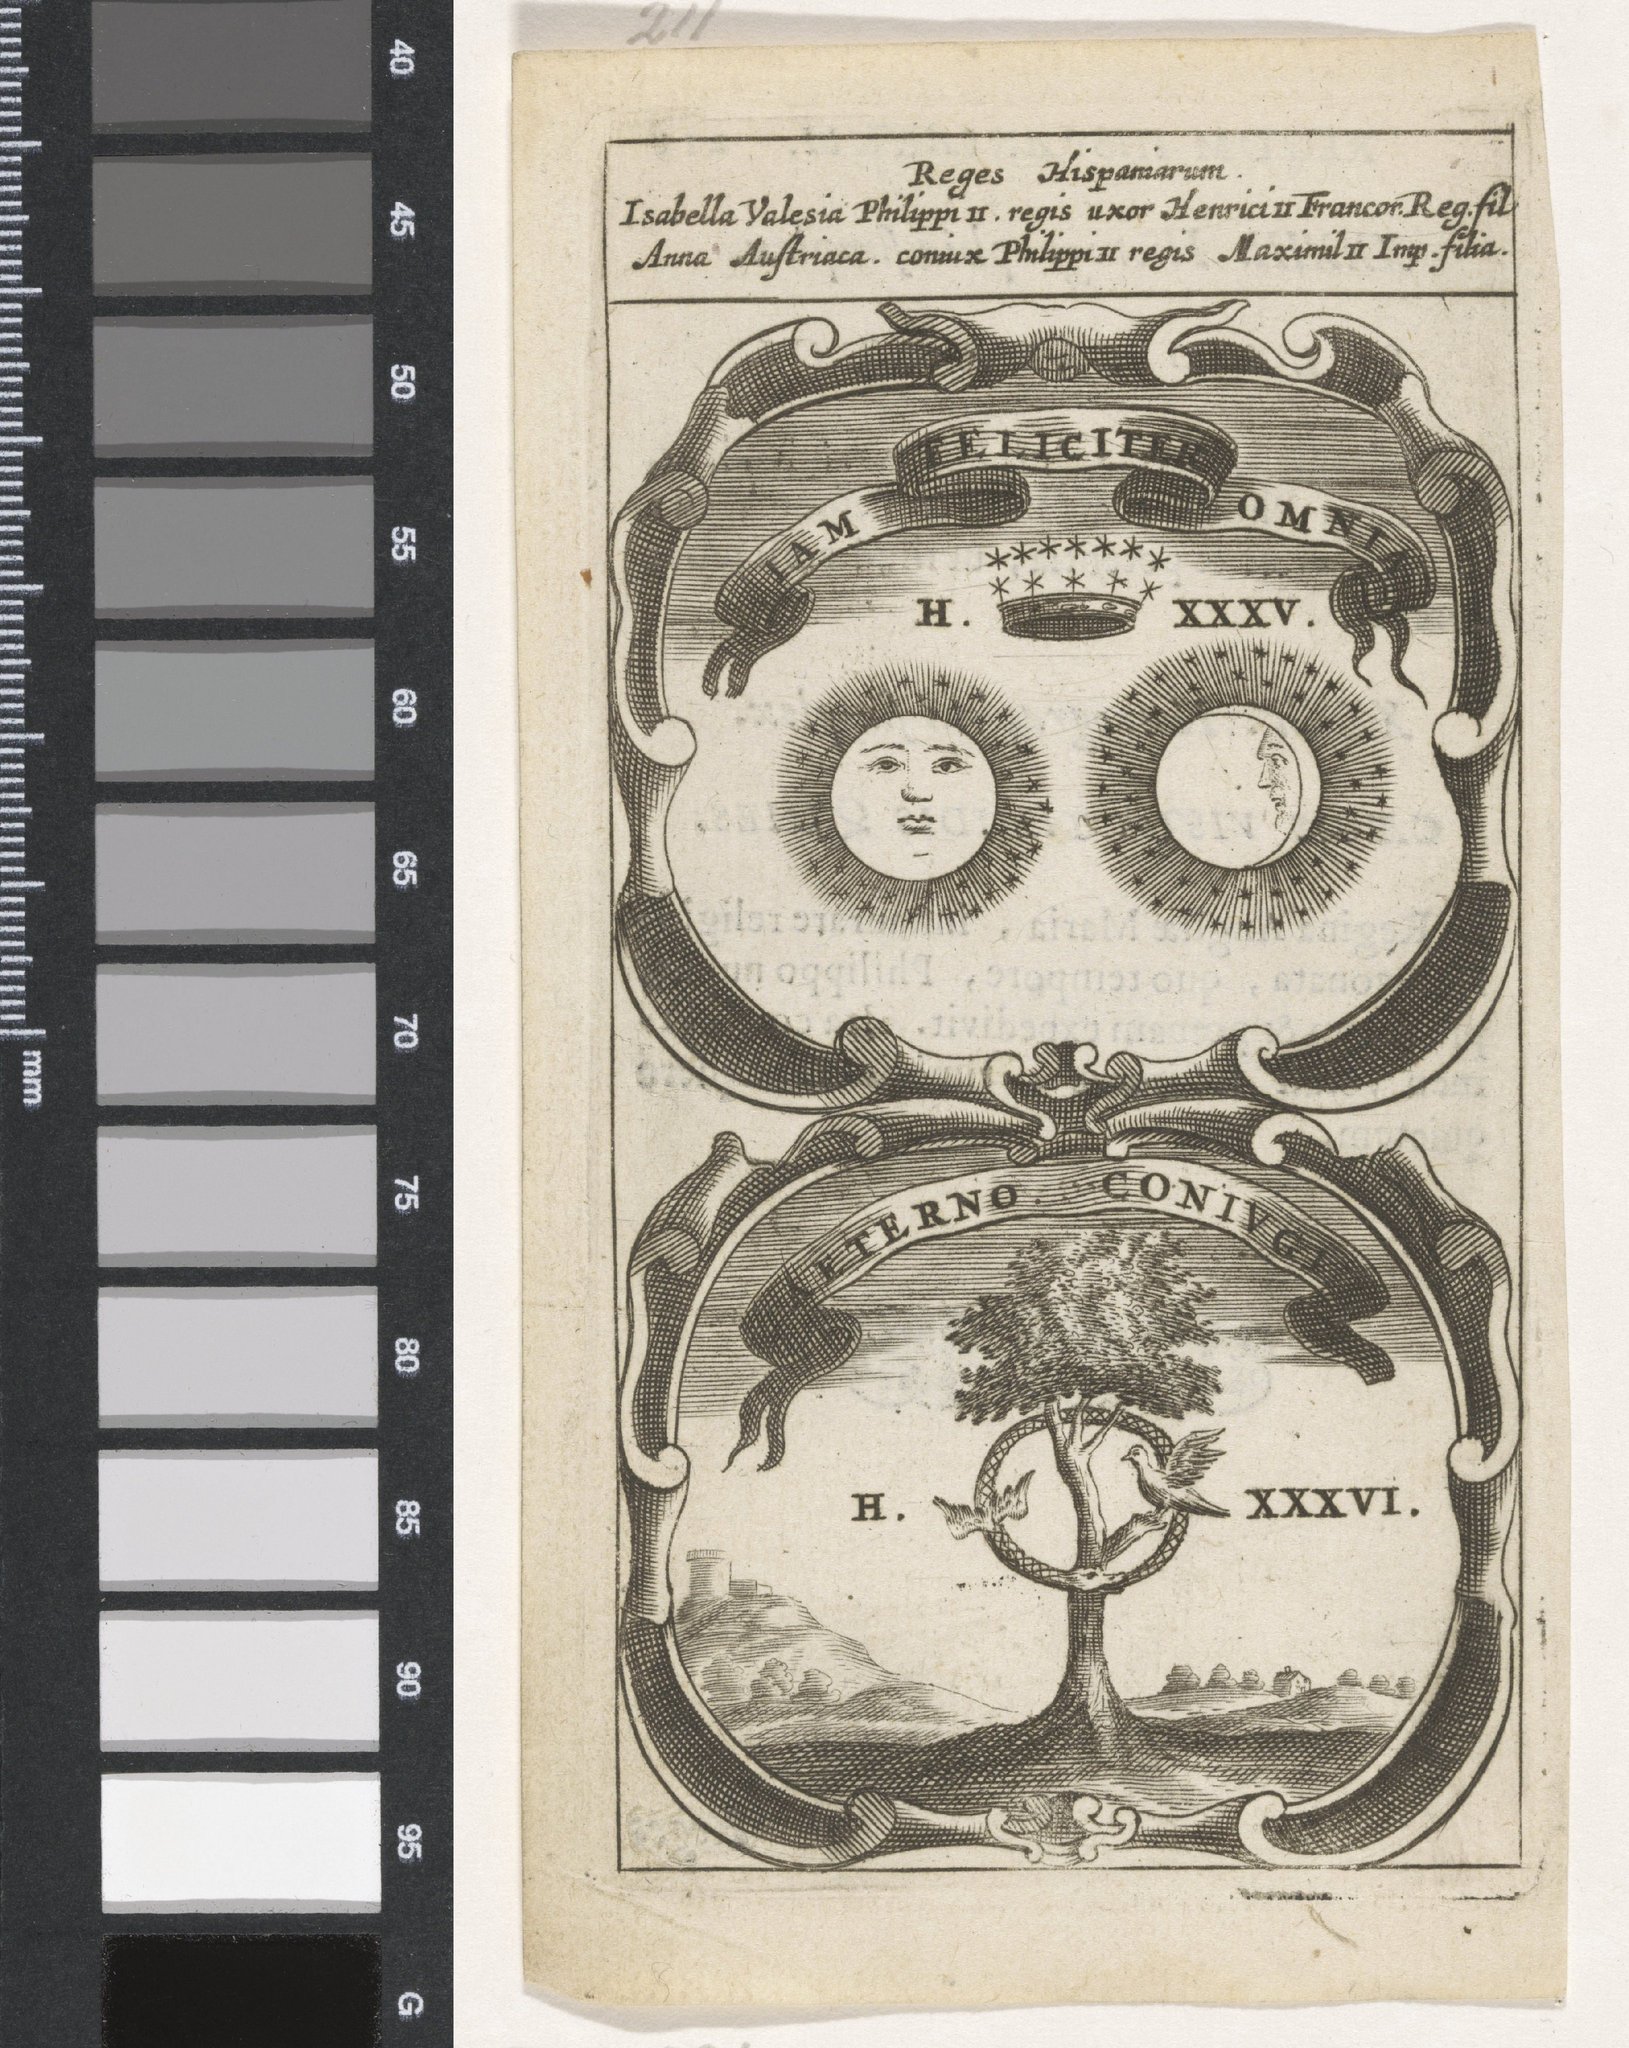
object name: print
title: Symbola Divina et Humana Pontificum Imperatorum Regum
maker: Anonymous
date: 1666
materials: paper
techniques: engraving, letterpress printing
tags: trees, full moon represented as face, other birds: dove, sun represented as face, wheel, etc., serpent ouroboros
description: Een embleem met twee voorstellingen. Boven een zon en een maan met daarboven een hemelkroon. Onder een landschap met een boom. OP een tak zit een duif. Om de boom een gevleugelde ouroboros. Het betreffen deviezen van Elisabeth van Frankrijk en Anna van Oostenrijk, vrouwen van koning Filips II.